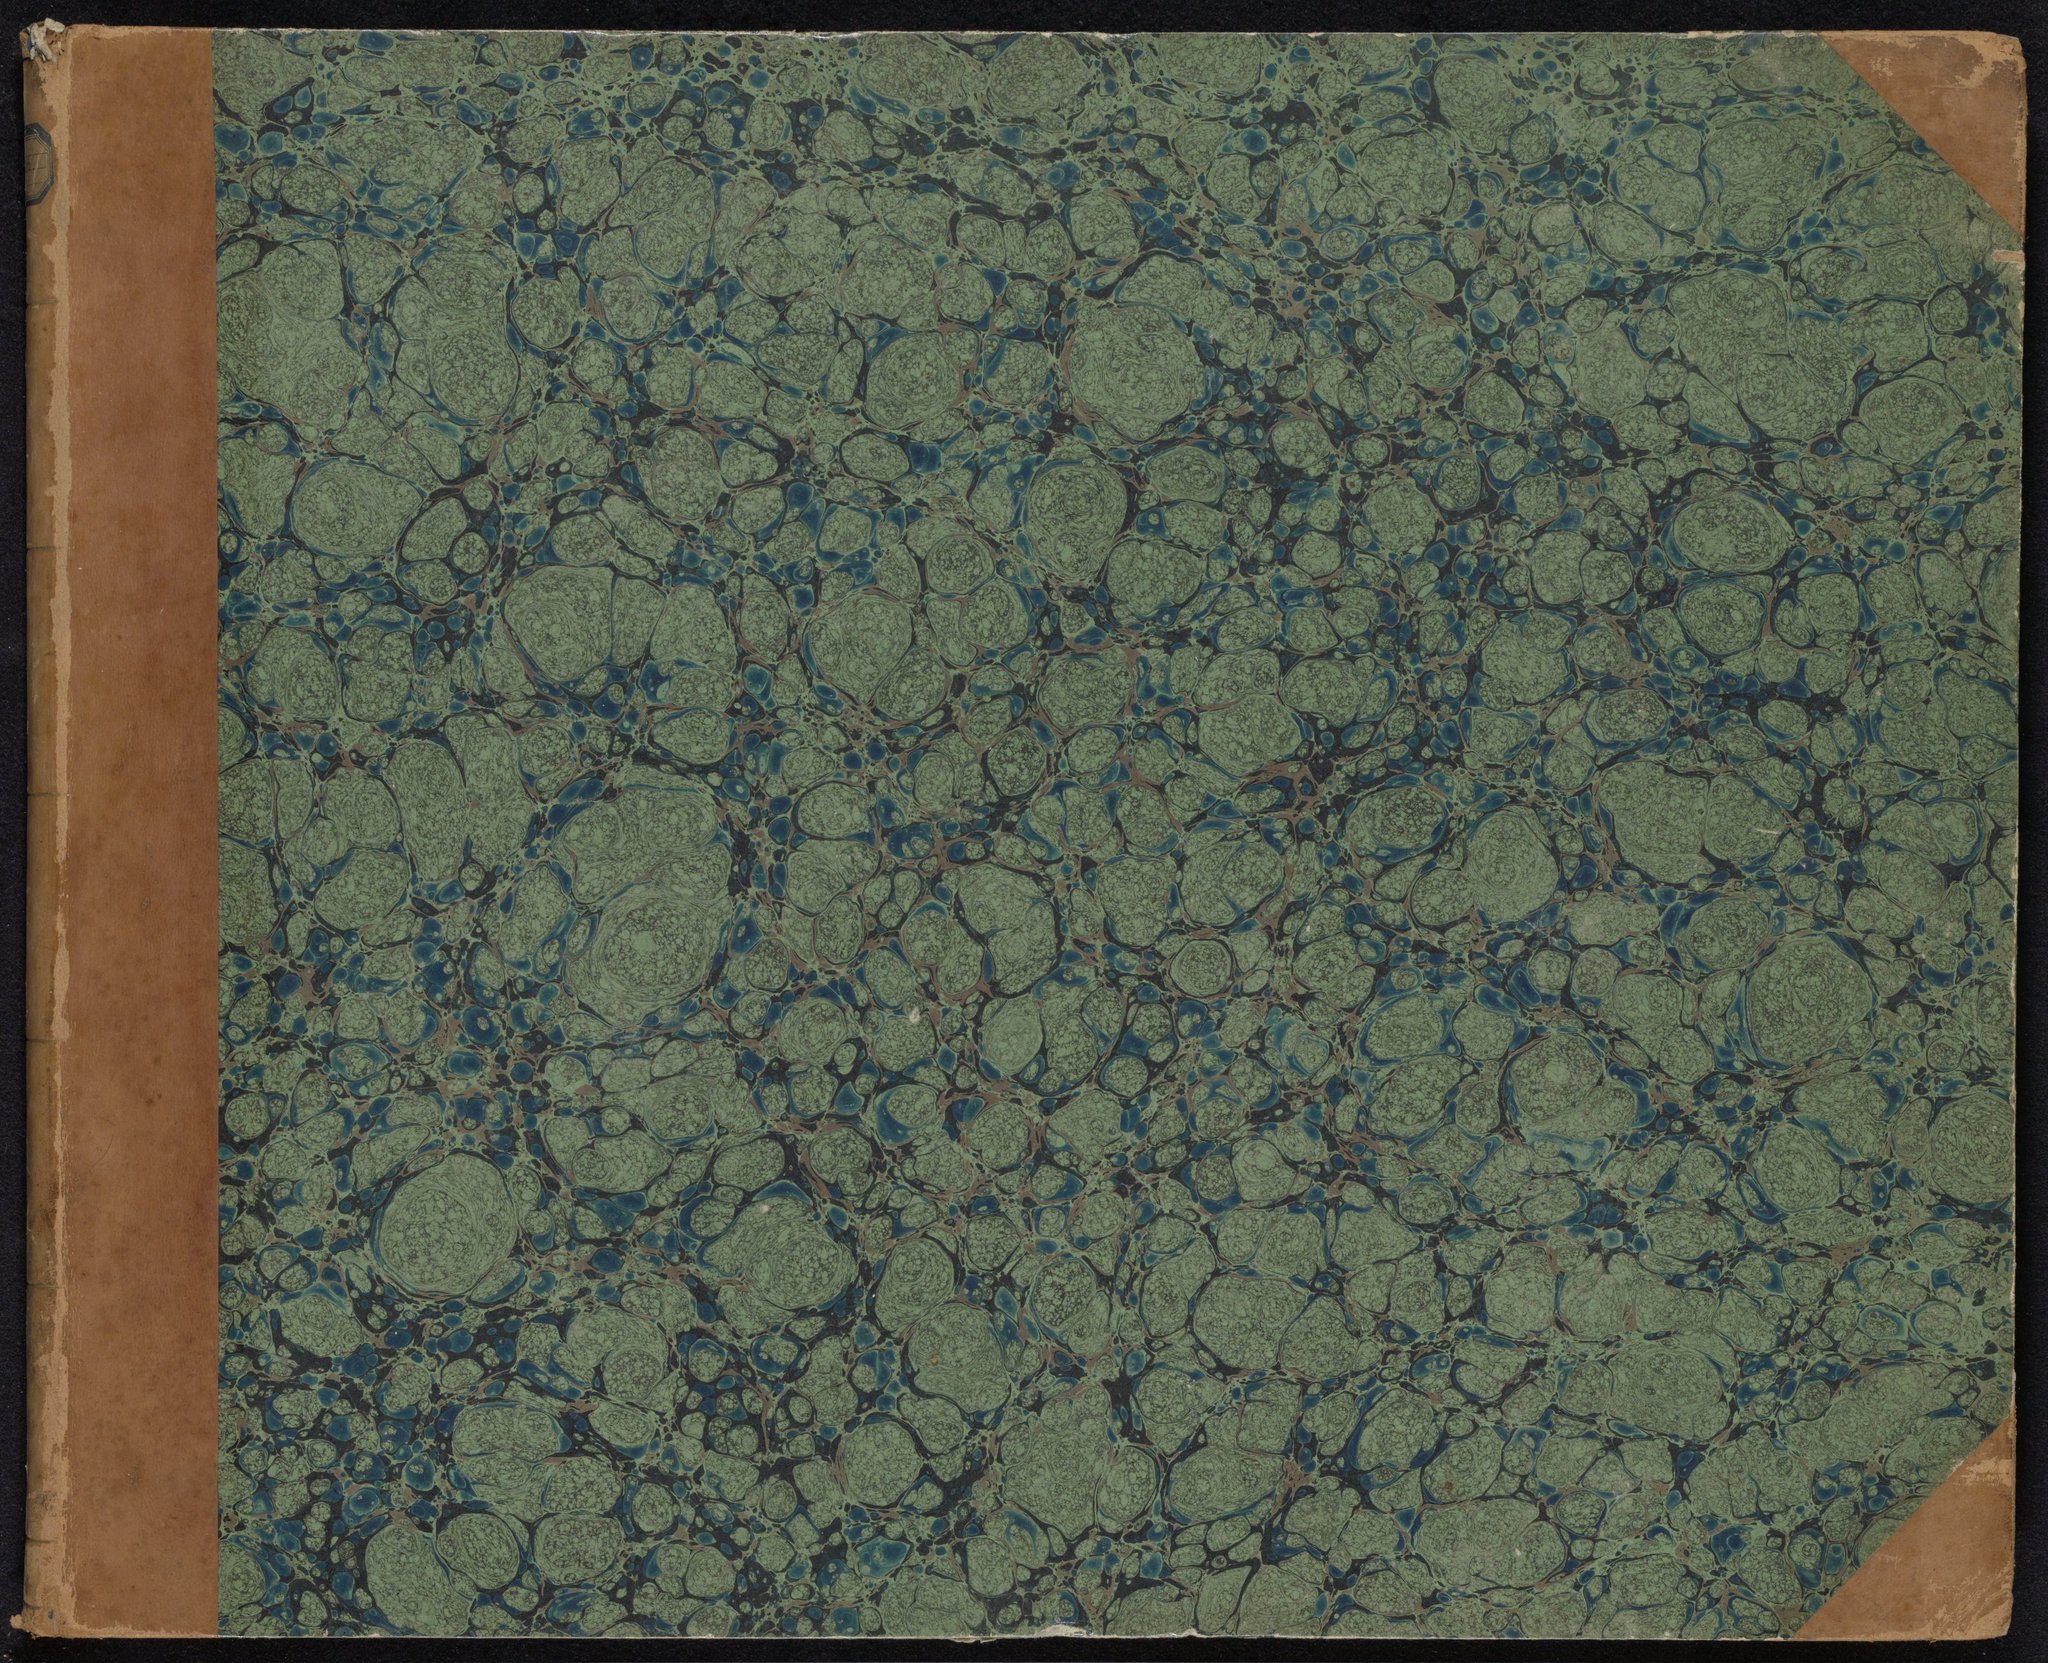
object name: prentrecueil, prentenalbum, prentalbum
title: Album met voorstellingen uit het Oude en het Nieuwe Testament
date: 1675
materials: cardboard, leather, paper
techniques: bookbinding, etching, marbling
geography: vatican city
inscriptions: number: ‘276’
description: Album met 54 prenten op 54 albumbladen. Het album bevat 54 prenten uit een reeks van 55 prenten, bestaande uit drie ongenummerde prenten en een set van 52 genummerde prenten naar de schilderingen in de Loggia van Rafaël. Een kartonnen band, beplakt met bruin leer en groen gemarmerd papier. Voorin en achterin een blanco schutblad.